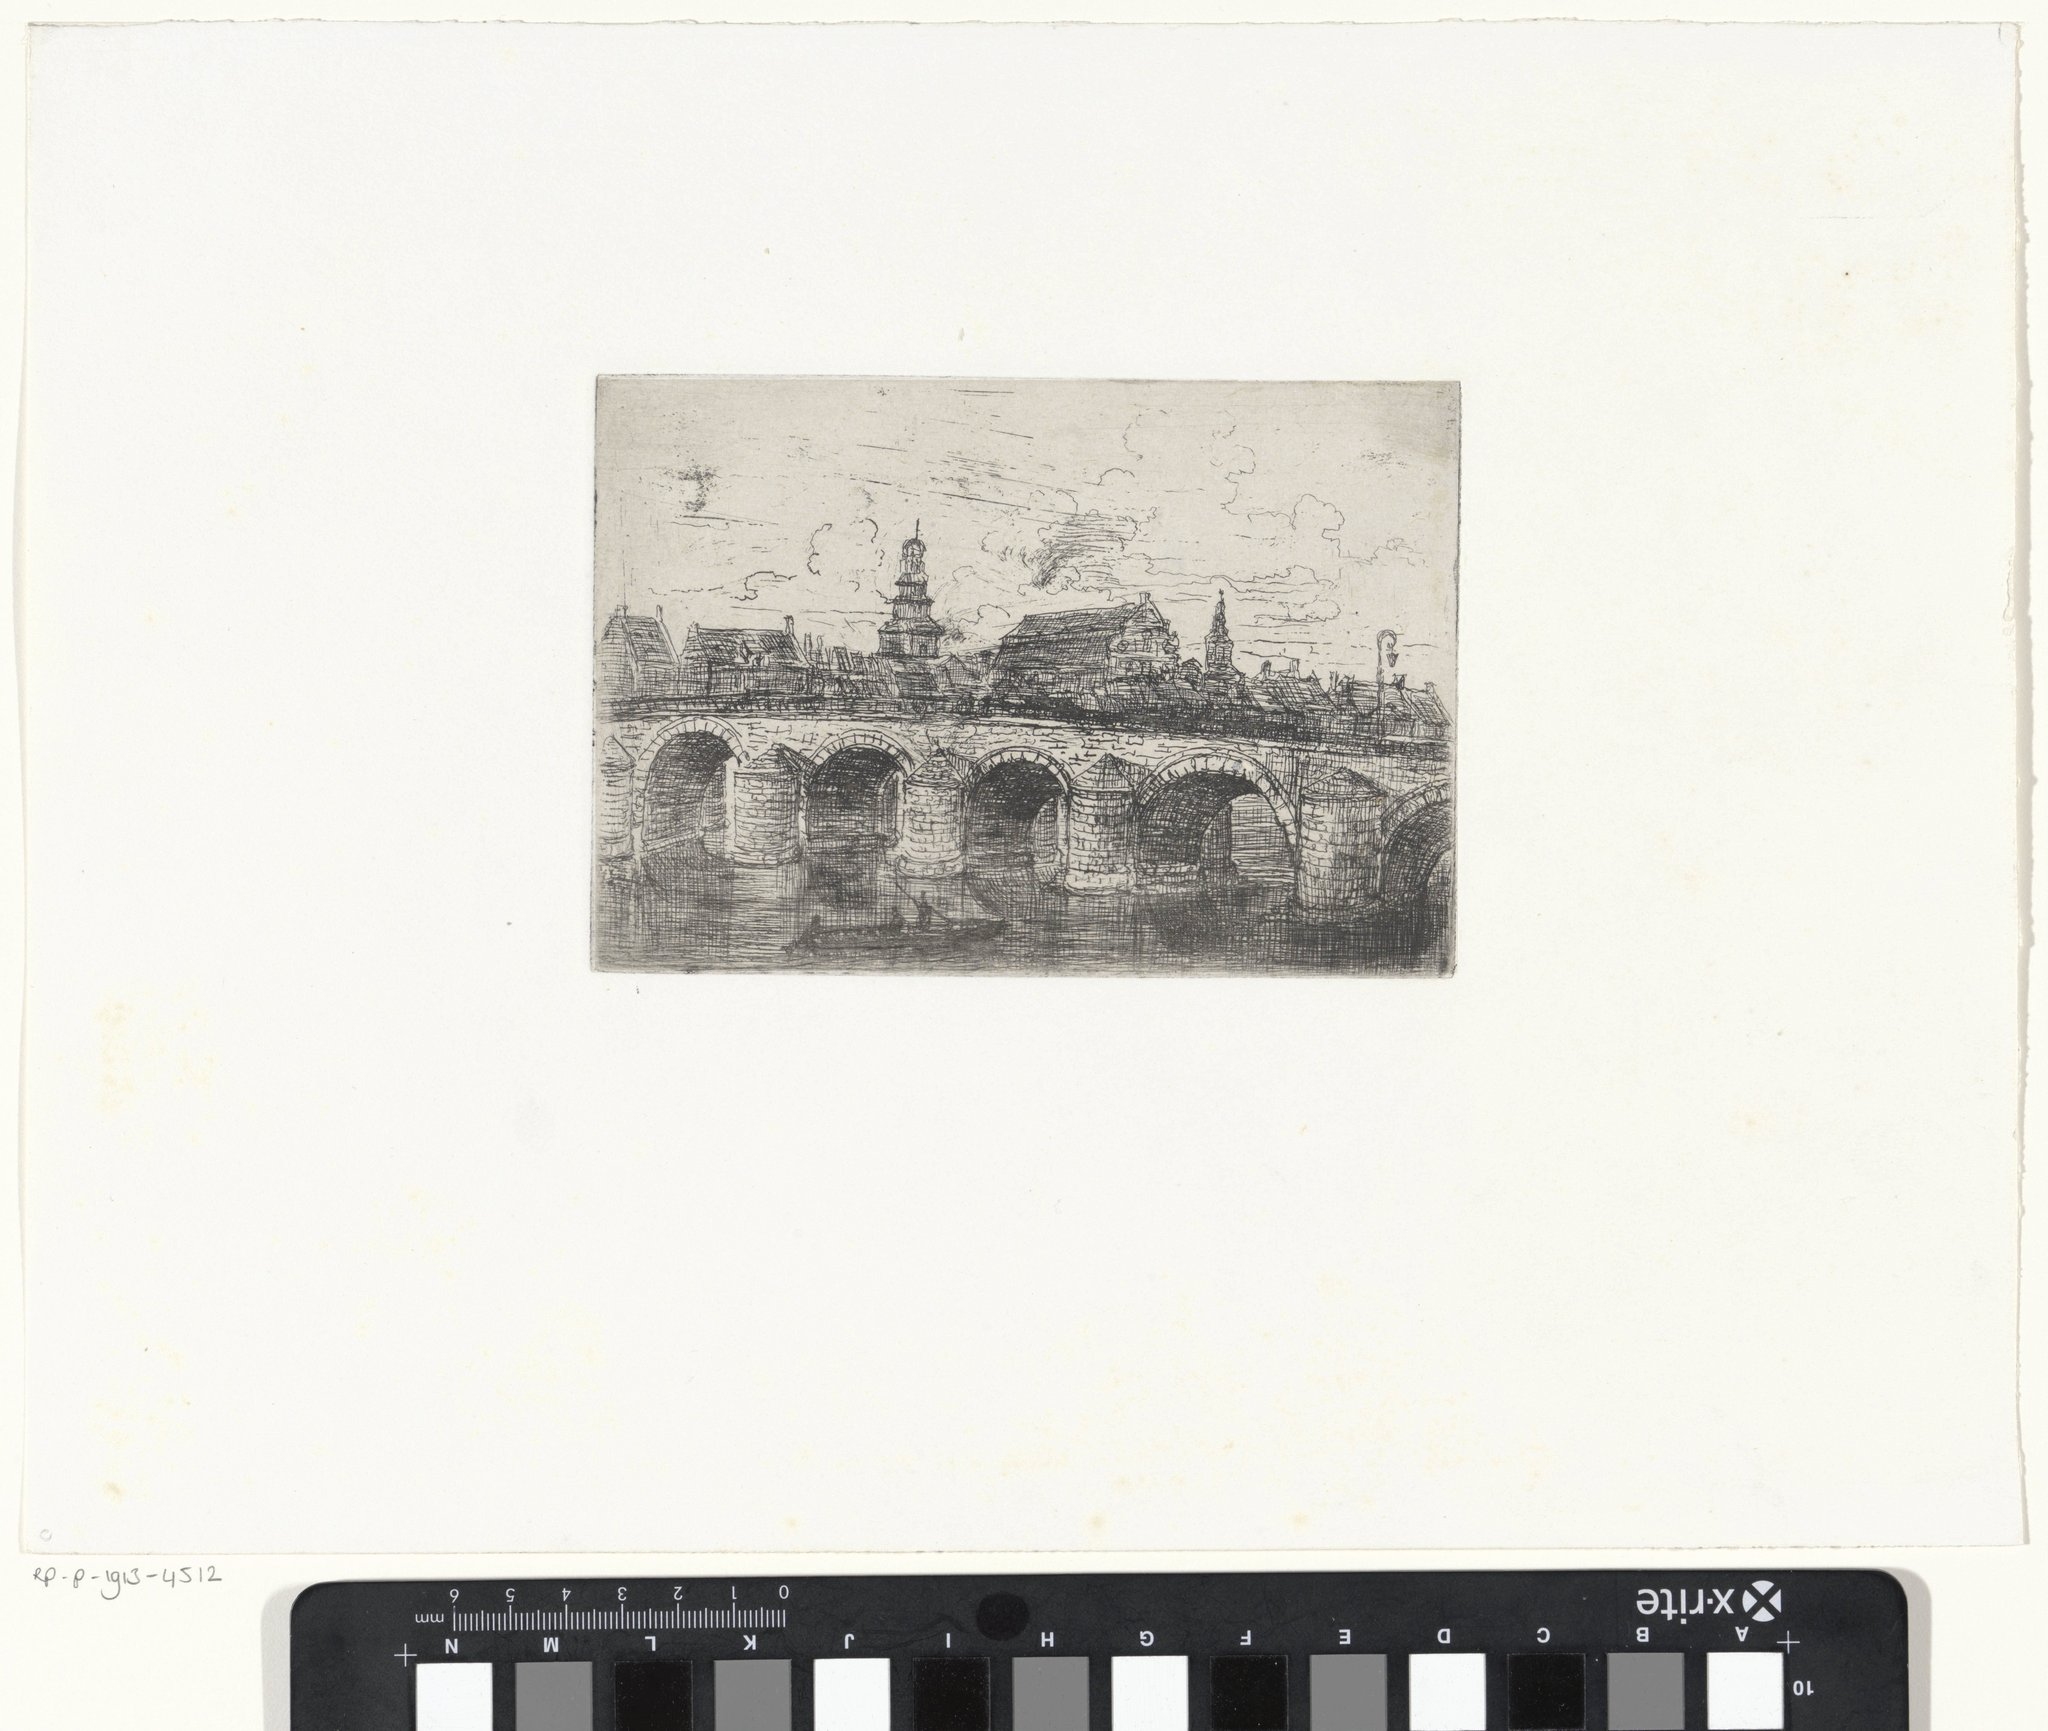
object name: print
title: Maasbrug te Maastricht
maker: alexander schaepkens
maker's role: draughtsman, print maker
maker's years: 1815-1899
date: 1830-1899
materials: paper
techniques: etching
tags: bridge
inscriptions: collector's mark: Lugt 2228